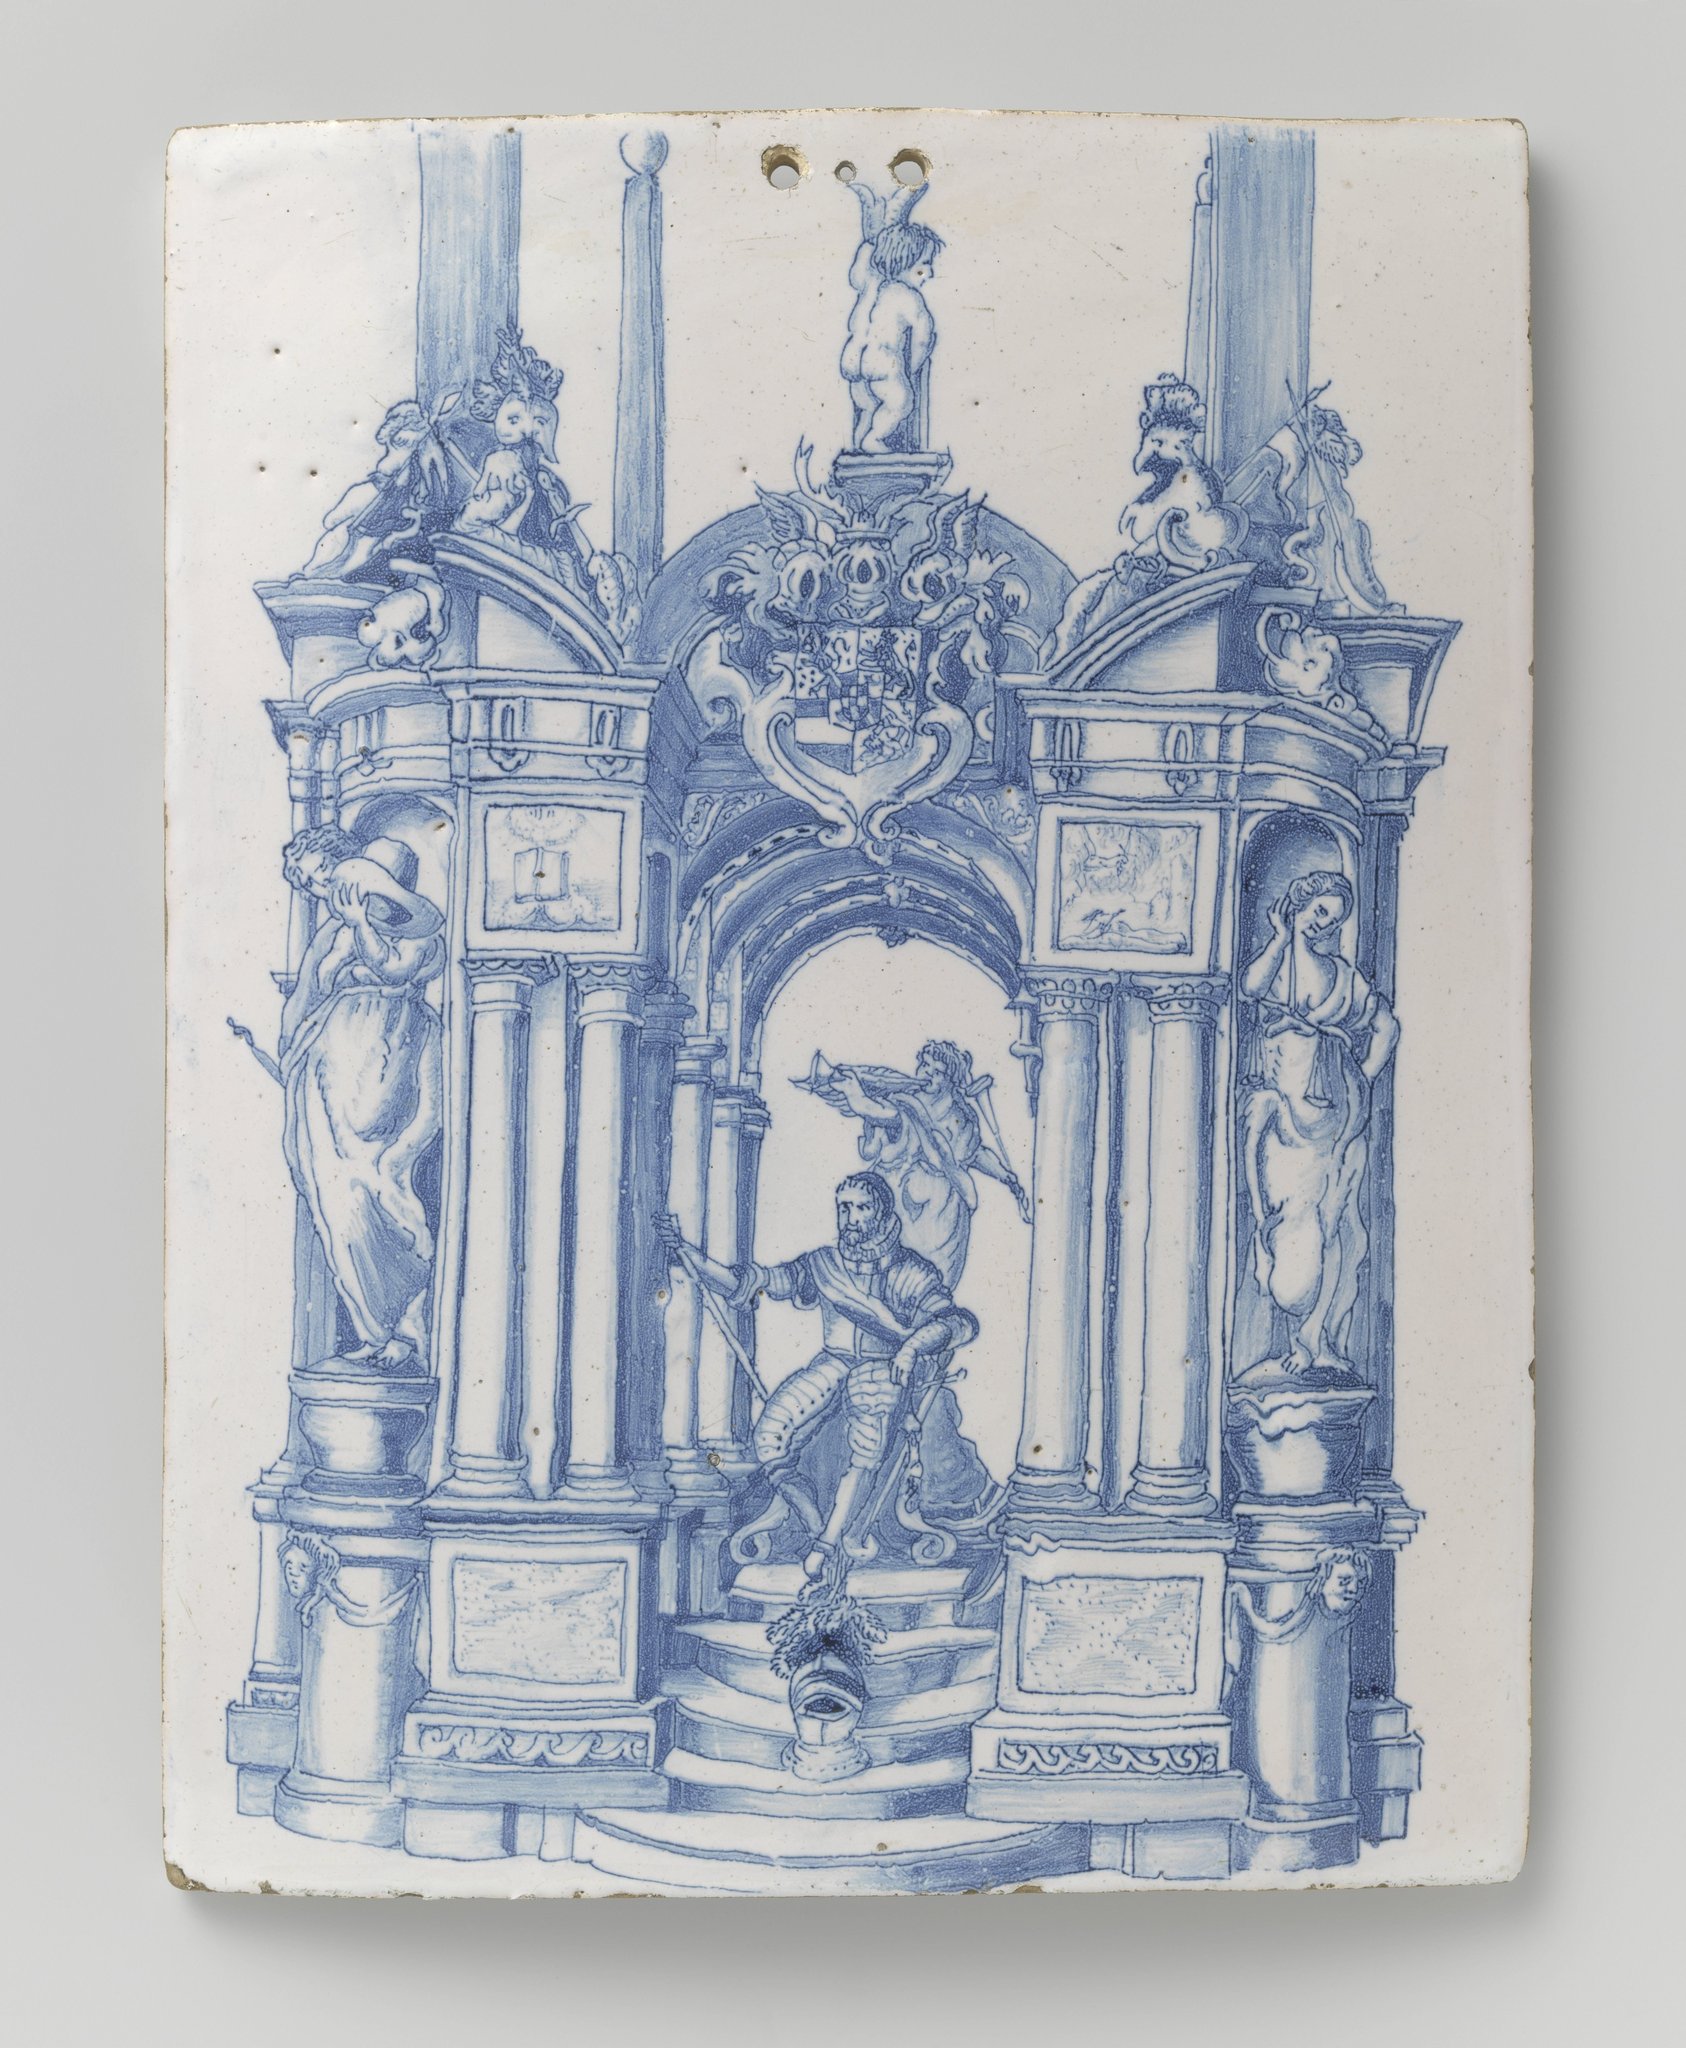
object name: plate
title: Two plaques with the Tomb of William of Orange in the Nieuwe Kerk in Delft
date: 1655-1665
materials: earthenware, glaze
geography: delft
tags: delft, william i (prince of orange), grave, tomb and other grave-forms and grave-markers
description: Plaat van faïence met het vooraanzicht van het graf van Willem van Oranje te Delft.